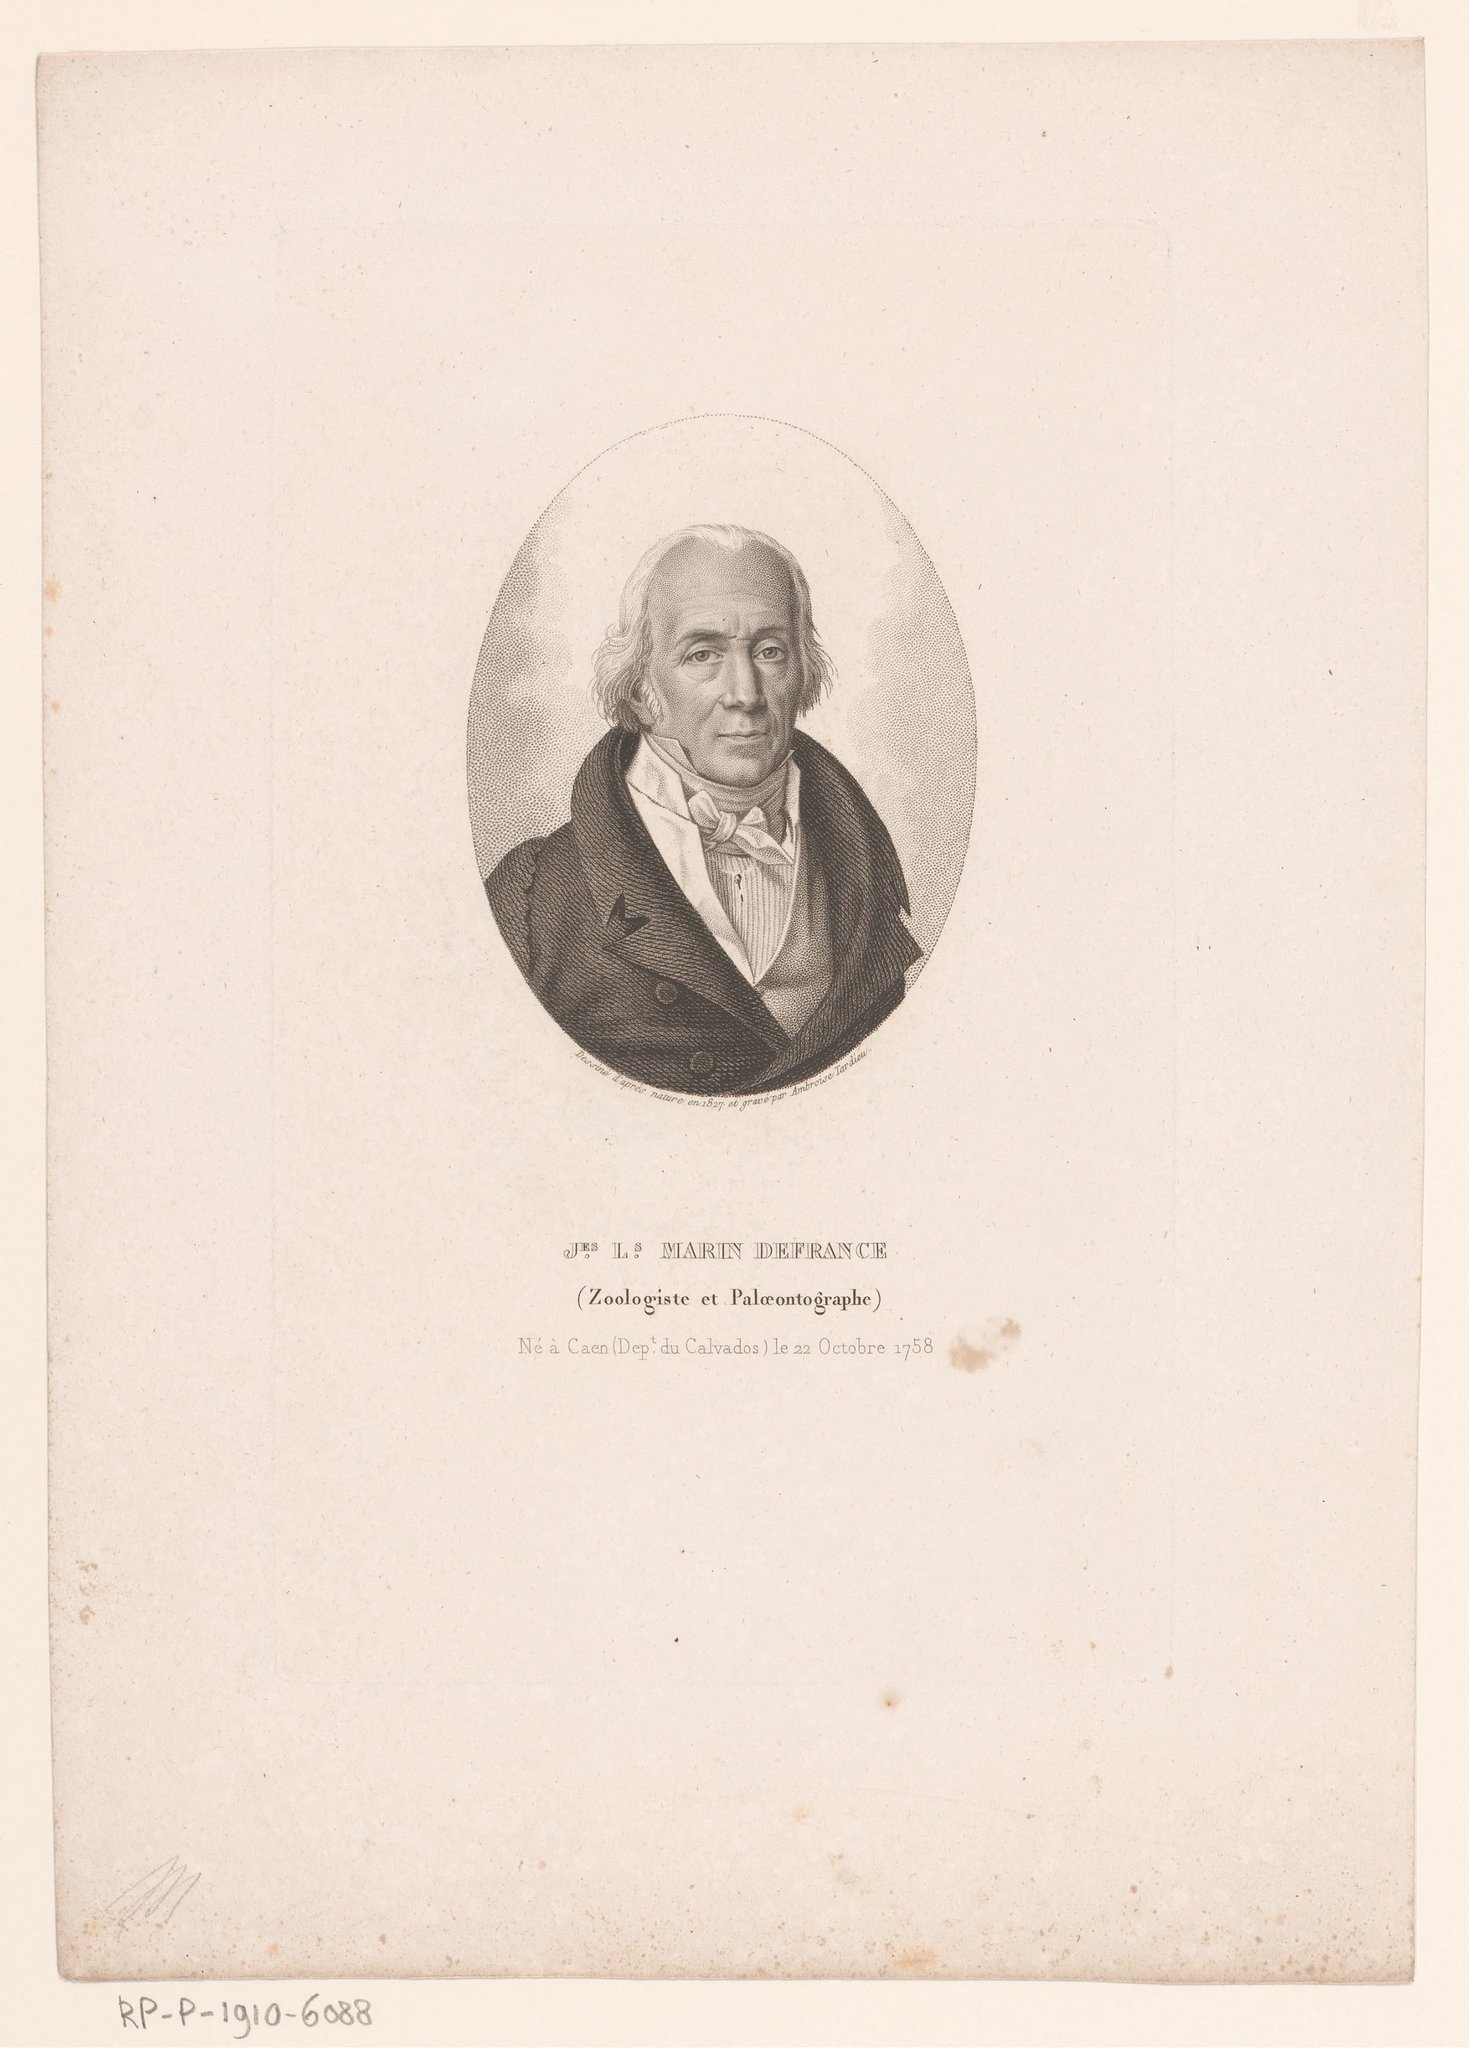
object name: print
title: Compleet overzicht van beroemdheden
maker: ambroise tardieu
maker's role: print maker, printer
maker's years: 1788-1841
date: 1827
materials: paper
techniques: engraving, roulette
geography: paris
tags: historical persons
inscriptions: collector's mark: Lugt 2228